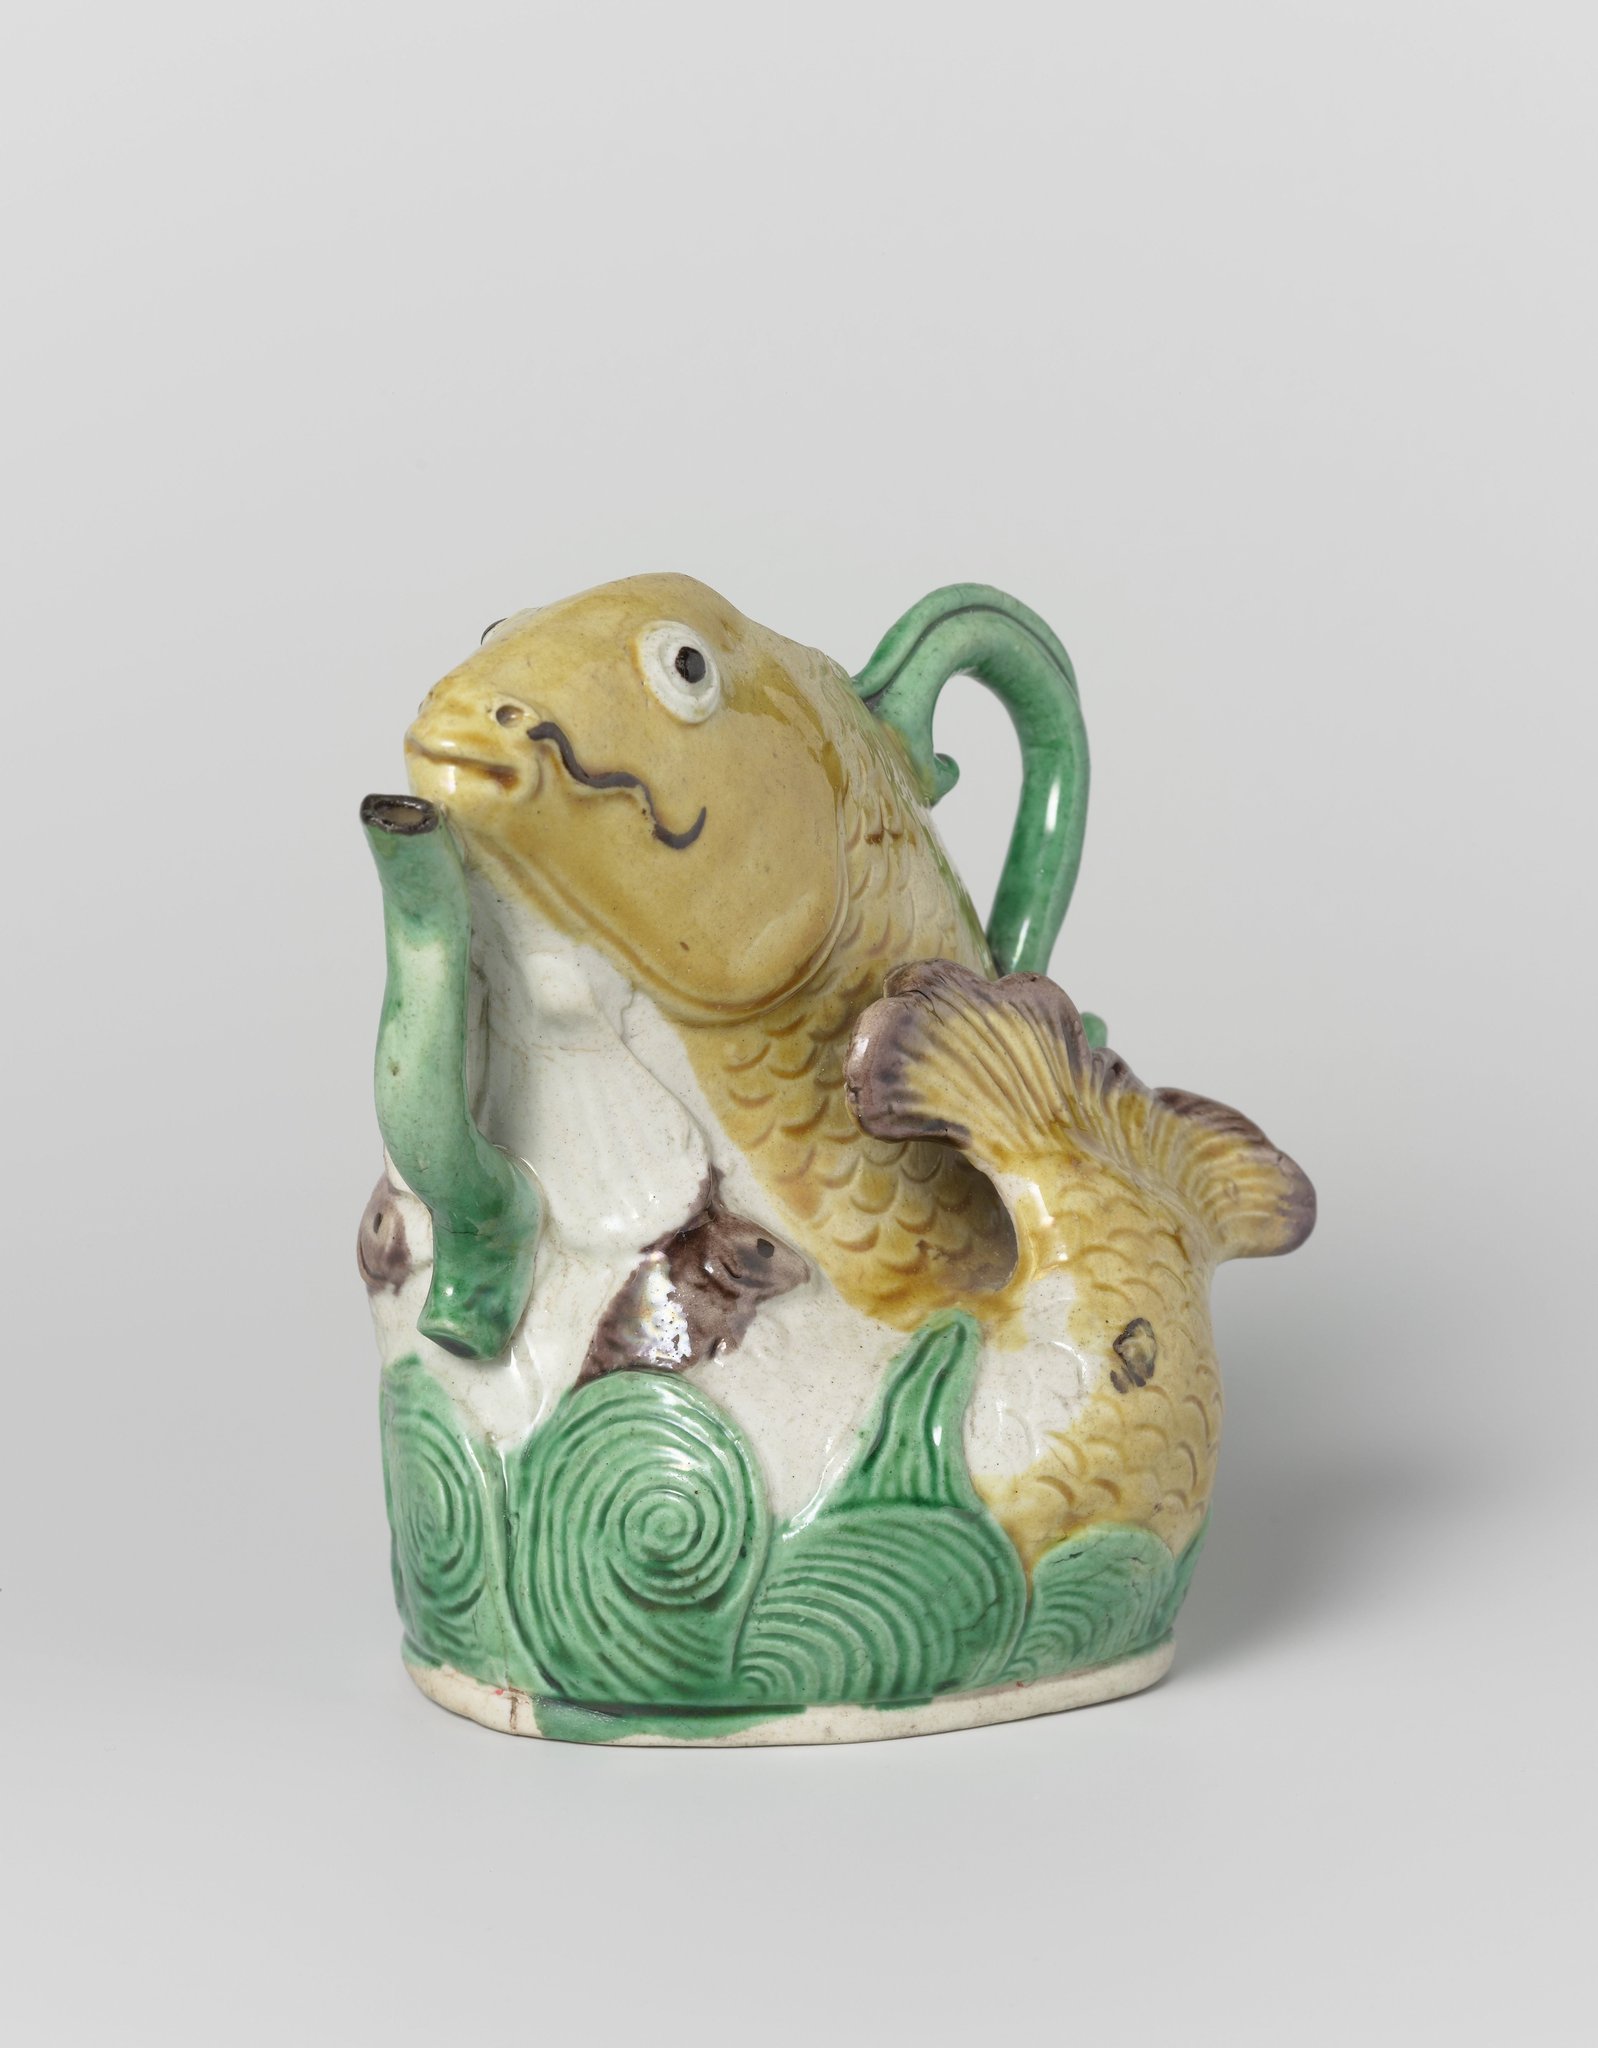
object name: ewer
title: Ewer in the shape of a carp leaping from the waves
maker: Anonymous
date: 1680-1720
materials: glaze, paint, porcelain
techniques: firing, forming, vitrification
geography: china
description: AK-NM-6539 Kan in de vorm van een vis • Emails sur biscuit • Onderdeel van Royers studiecollectie (inventaris Van de Kasteele 1816, nr. 290) • Gepubliceerd: Jörg 1997, nr. 202. Kannen in de vorm van een vis of een kreeft met groene en gele emails zijn bekend uit de 16de eeuw; Royers exemplaar is een voorbeeld uit de late 17de eeuw, toen ze blijkbaar opnieuw in de mode waren. Misschien was de oorspronkelijke functie een wijnkan, voor Chinese liefhebbers, of een waterkan voor de literaat, of een kan voor heet water bij de thee. In ieder geval was het een aantrekkelijk voorwerp dat ook buiten China geliefd was. Dat blijkt uit de vele verwijzingen naar andere (Westerse) collecties (Jörg), waar zich soortgelijke kannen bevinden. In Japan waren ze geliefd als onderdeel van de theeceremonie [Honda en Shimazu 1993, nrs. 151 en 158]. In Europa schonk in 1590 de ene vorst twee soortgelijke kannen aan de andere: Ferdinando de Medici (1549-1609) schonk een groepje porselein aan Christiaan I, keurvorst van Saksen (1560-1591) [Ströber 2006]. En ook uit het achttiende-eeuwse Frankrijk is de belangstelling voor deze kannen bekend. De tekenaar Gabriel de Saint-Aubin (1724-1780) maakte schetsjes in de marge van de veilingcatalogus van de collectie van Louis-Jean Gaignat (1697-1768). Eén daarvan is precies zo’n kan in de vorm van een vis [Sargent 1991, pp. 78-79, nr. 30]. Royers kan in de vorm van een vis is dus een gebruiksvoorwerp en een verzamelobject bij uitstek. Bronnen: William R. Sargent, The Copeland collection: Chinese and Japanese ceramic figures, Salem, 1991. Hiromu Honda and Noriki Shimazu, Vietnamese and Chinese ceramics used in the Japanese tea ceremony, Singapore, 1993. Christiaan J.A. Jörg, Chinese ceramics in the collection of the Rijksmuseum, Amsterdam: the Ming and Qing dynasties, Londen, 1997. Eva Ströber, ‘Porzellan als Geschenk des Grossherzogs Ferdinando I de‘ Medici aus dem Jahre 1590‘, in: D. Syndram and M. Woelk (eds.), Giambologna in Dresden - Die Geschenke der Medici, München Berlijn 2006.